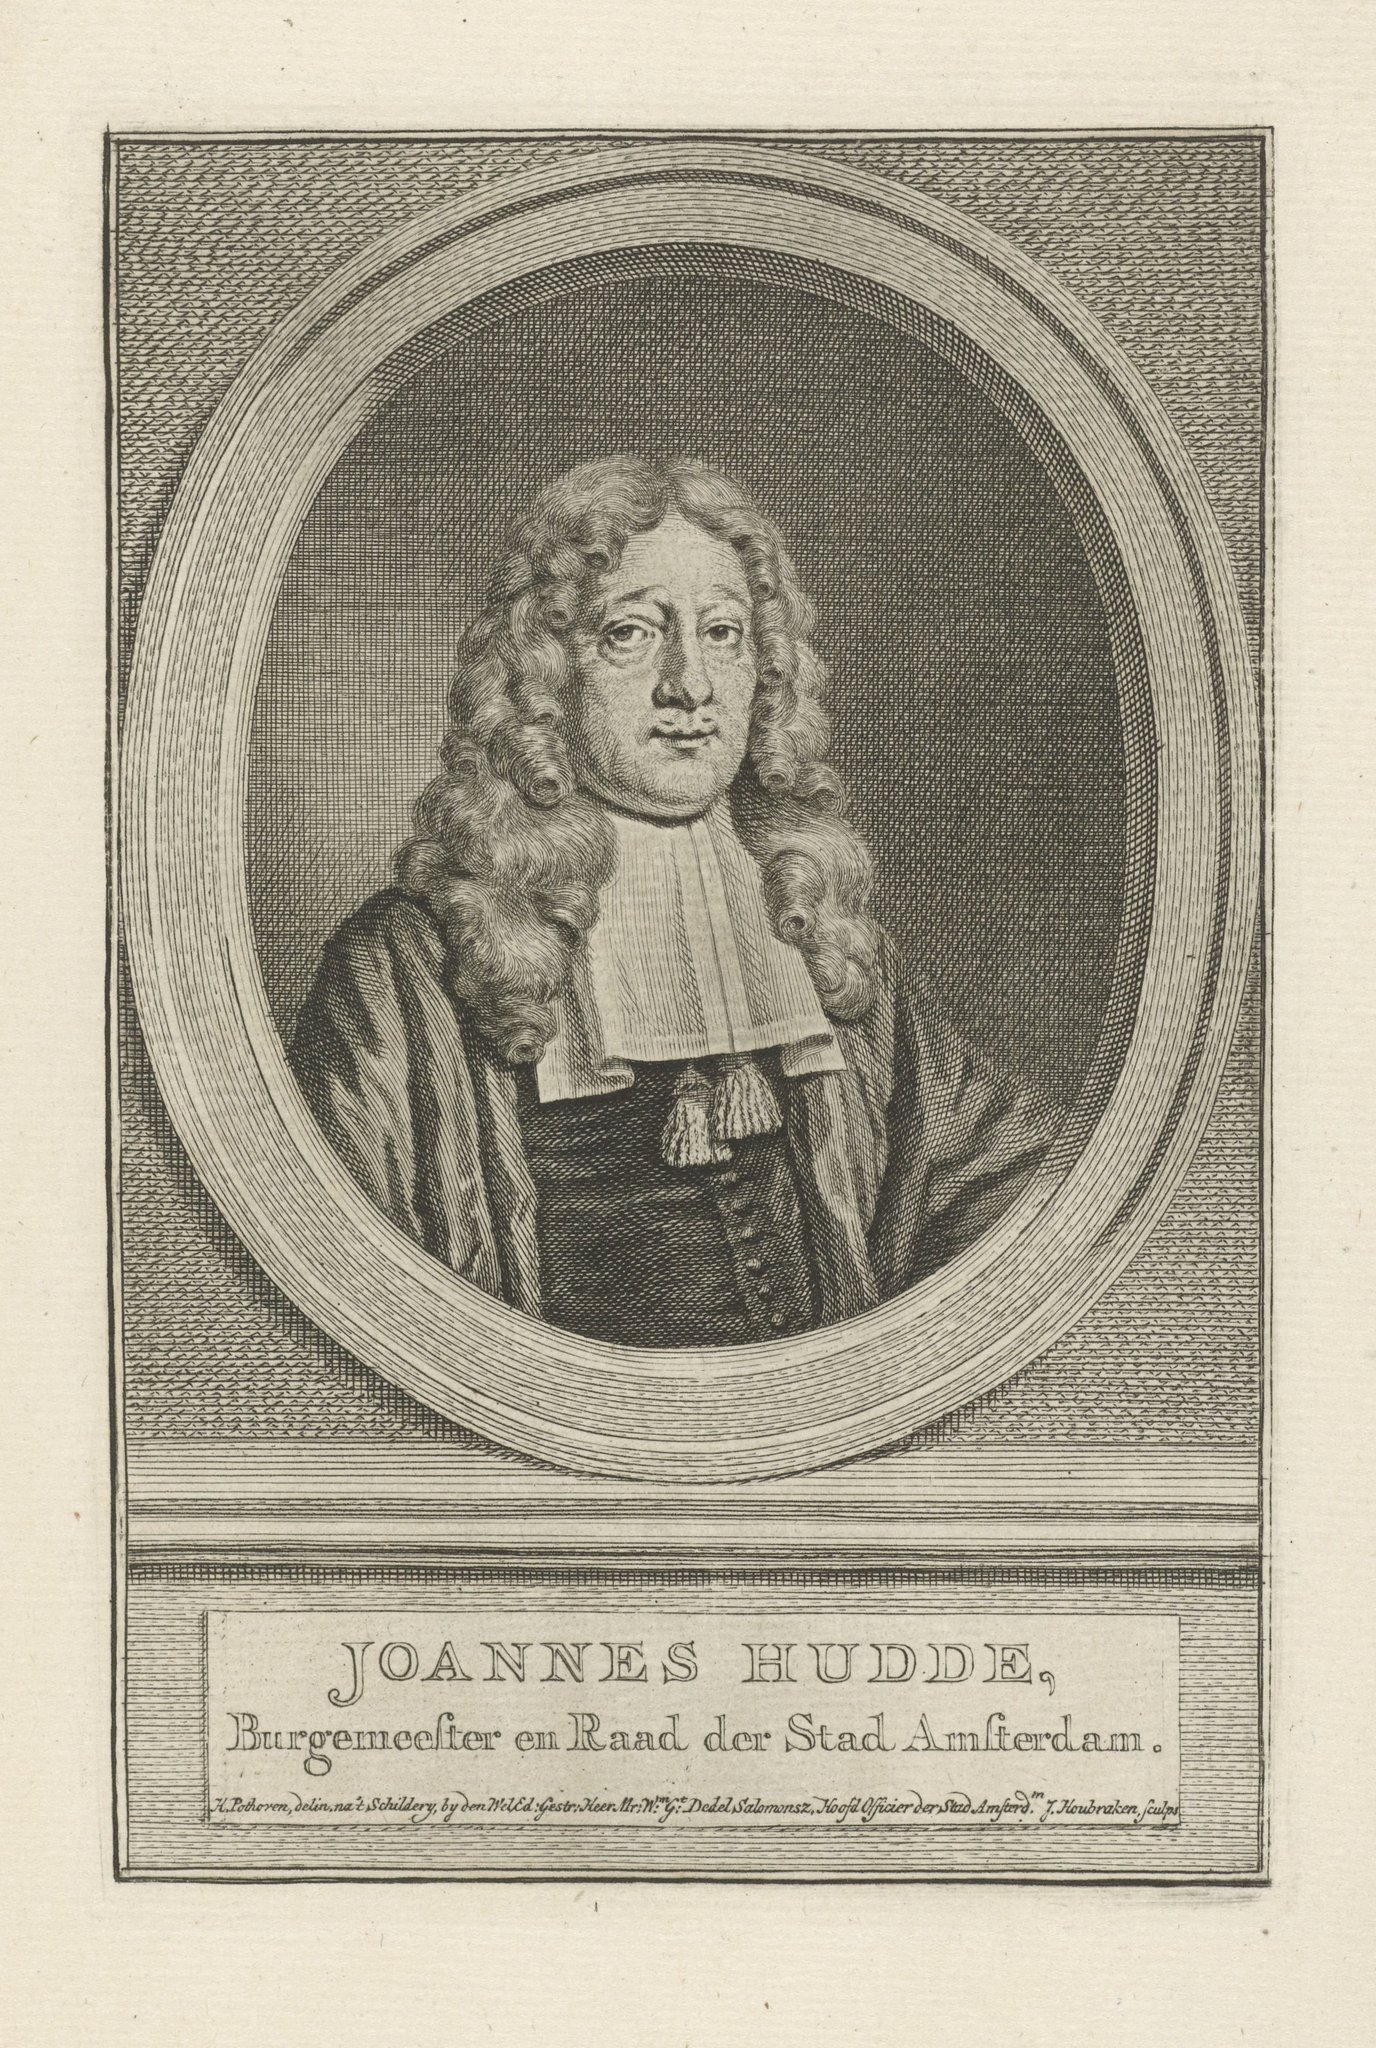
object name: print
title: Portret van Johannes Hudde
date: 1749-1780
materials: paper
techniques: engraving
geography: amsterdam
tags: johannes hudde, historical persons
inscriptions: collector's mark: Lugt 2228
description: Deze prent is oorspronkelijk bedoeld als aanvulling op Jan Wagenaars ‘Vaderlandsche historie’* en was zo vanaf 1796 verkrijgbaar bij Johannes Allart te Amsterdam. Voor de advertentie waarin Allart de 60 portretten en 7 platen, allen gegraveerd door Houbraken, ter aanvulling op Wagenaars ‘Vaderlandsche historie’ aanbiedt, zie RP-P-OB-77.766. *Van dit werk zijn in de achttiende eeuw meerdere uitgaves verschenen, zoals: Wagenaar, Jan. Vaderlandsche historie, vervattende de geschiedenissen der Vereenigde Nederlanden (…). 21 delen. Amsterdam: Isaak Tirion, 1749-1759. Wagenaar, Jan. Vaderlandsche historie, vervattende de geschiedenissen der nu Vereenigde Nederlanden (…). 21 delen. Amsterdam: weduwe Isaak Tirion, 1770. Wagenaar, Jan. Vaderlandsche historie, vervattende de geschiedenissen der nu Vereenigde Nederlanden (…). 21 delen. Amsterdam, Leiden, Dordrecht en Harlingen: P. Schouten e.a., 1782. Wagenaar, Jan. Vaderlandsche historie, vervattende de geschiedenissen der nu Vereenigde Nederlanden (…). 21 delen. Amsterdam: Johannes Allart, 1790-1796.